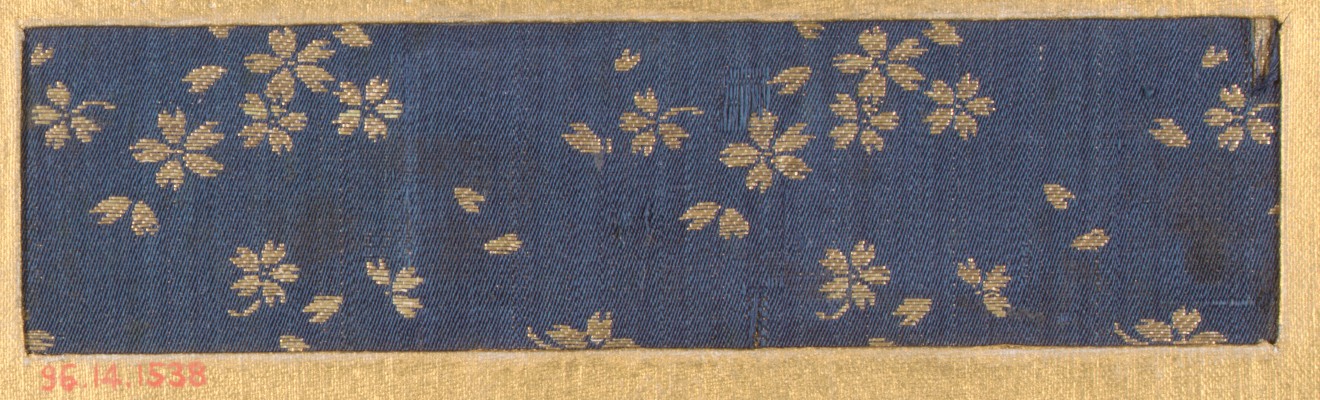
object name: piece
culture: japanese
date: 1701-1900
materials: silk